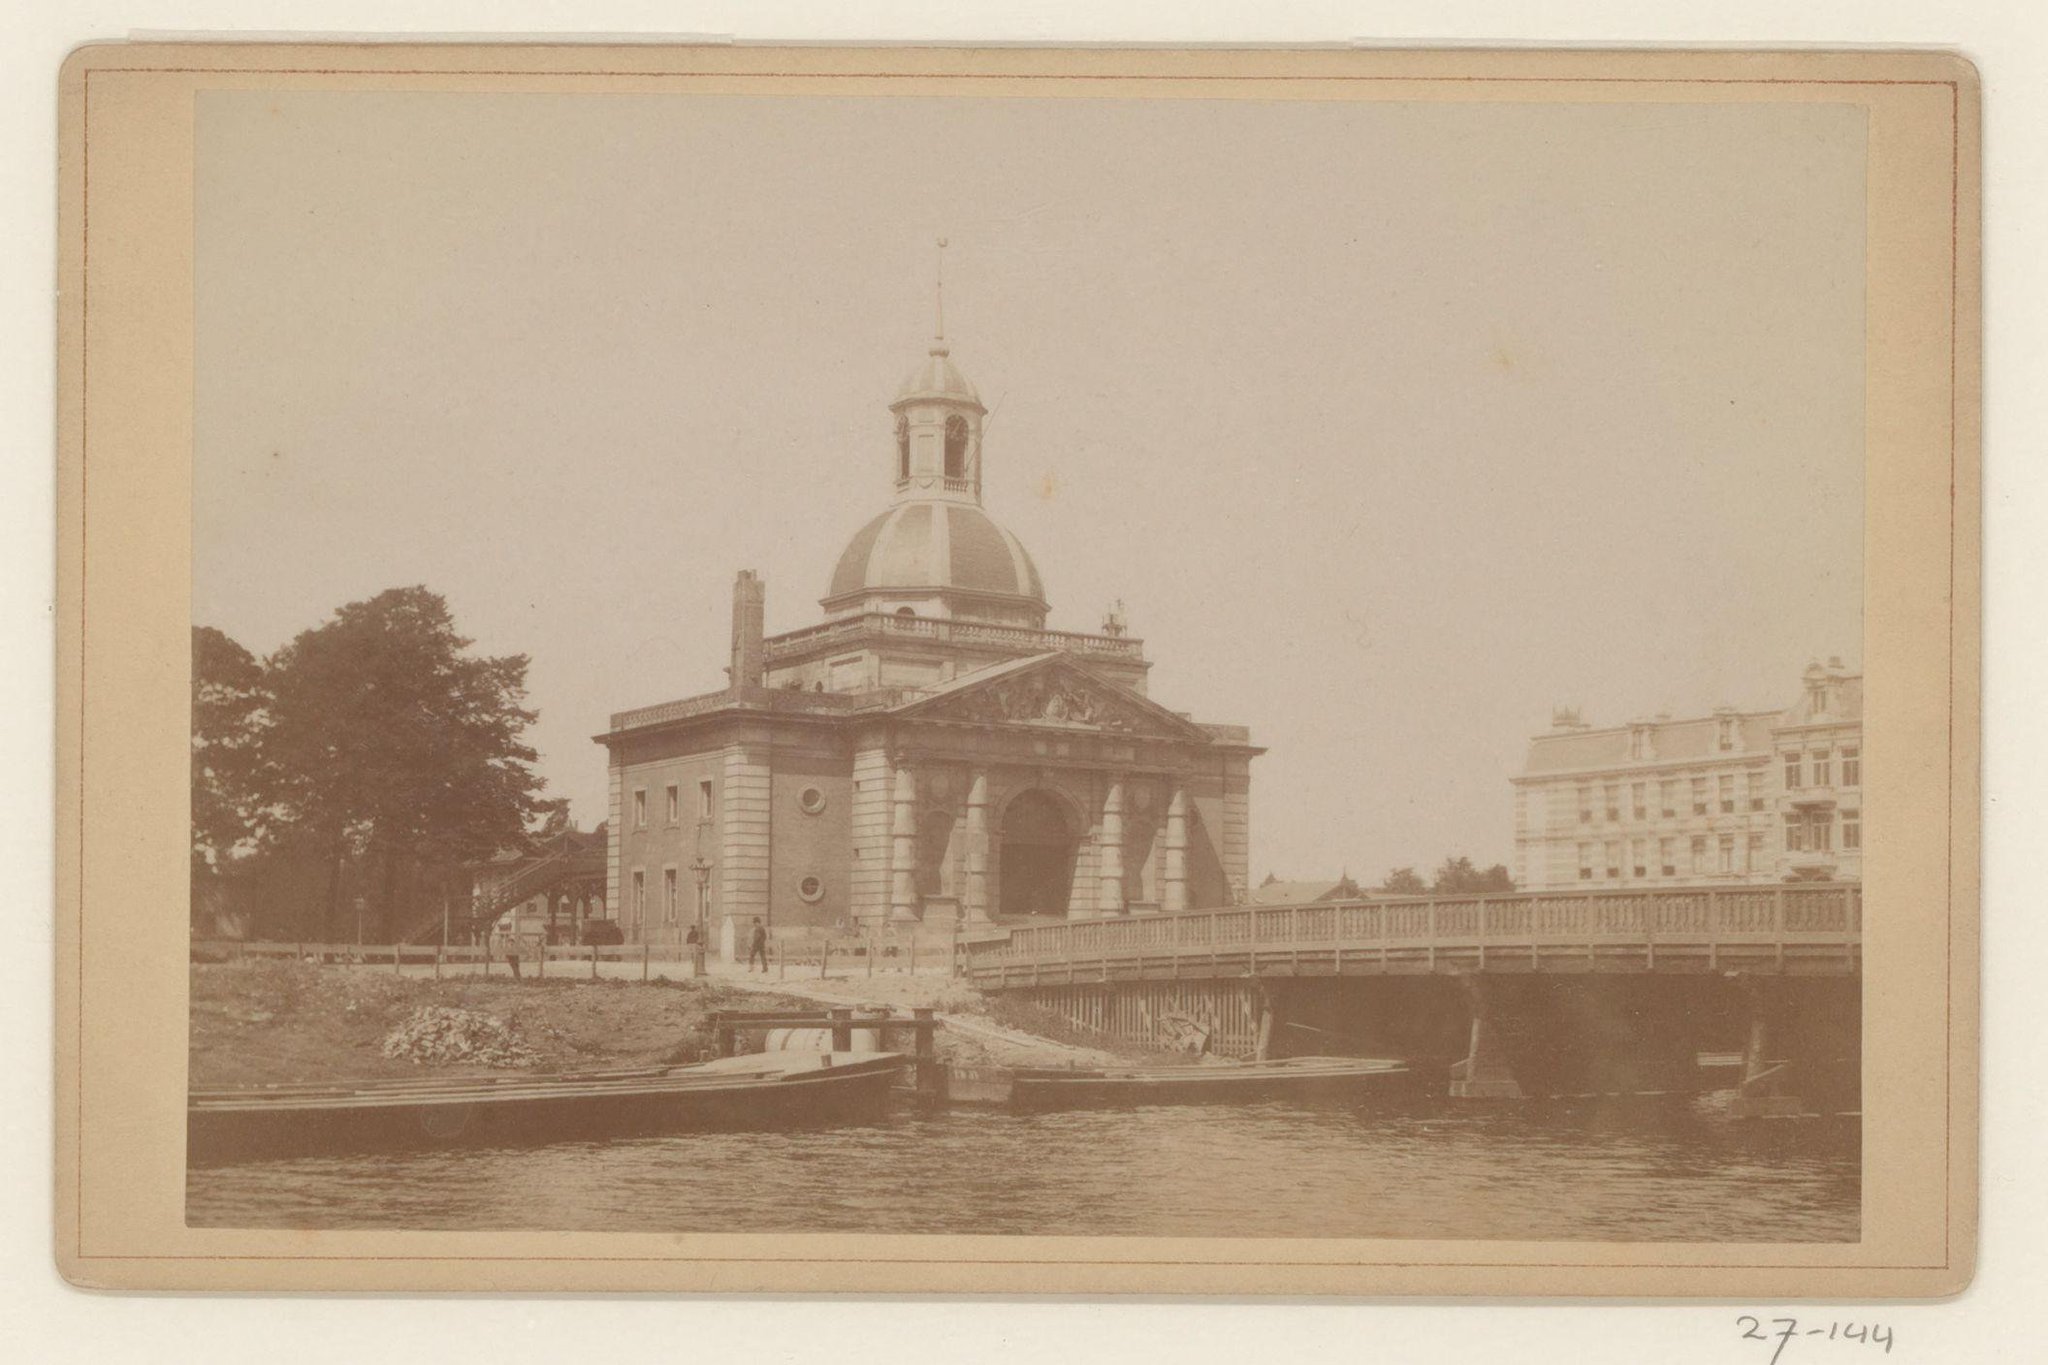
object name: cabinet photograph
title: Gezicht op de Tweede Muiderpoort te Amsterdam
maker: Anonymous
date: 1886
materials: cardboard, paper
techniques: albumen print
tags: city-gate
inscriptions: inscription: ‘D. Muiderpoort met de hulpbrug van de tram (...) voorjaar 1886’, collector's mark: Lugt 1641b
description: Onderwerpsrubriek binnen de Atlas Amsterdam: Poorten, verzamelbladen, J. Tweede Muiderpoort.